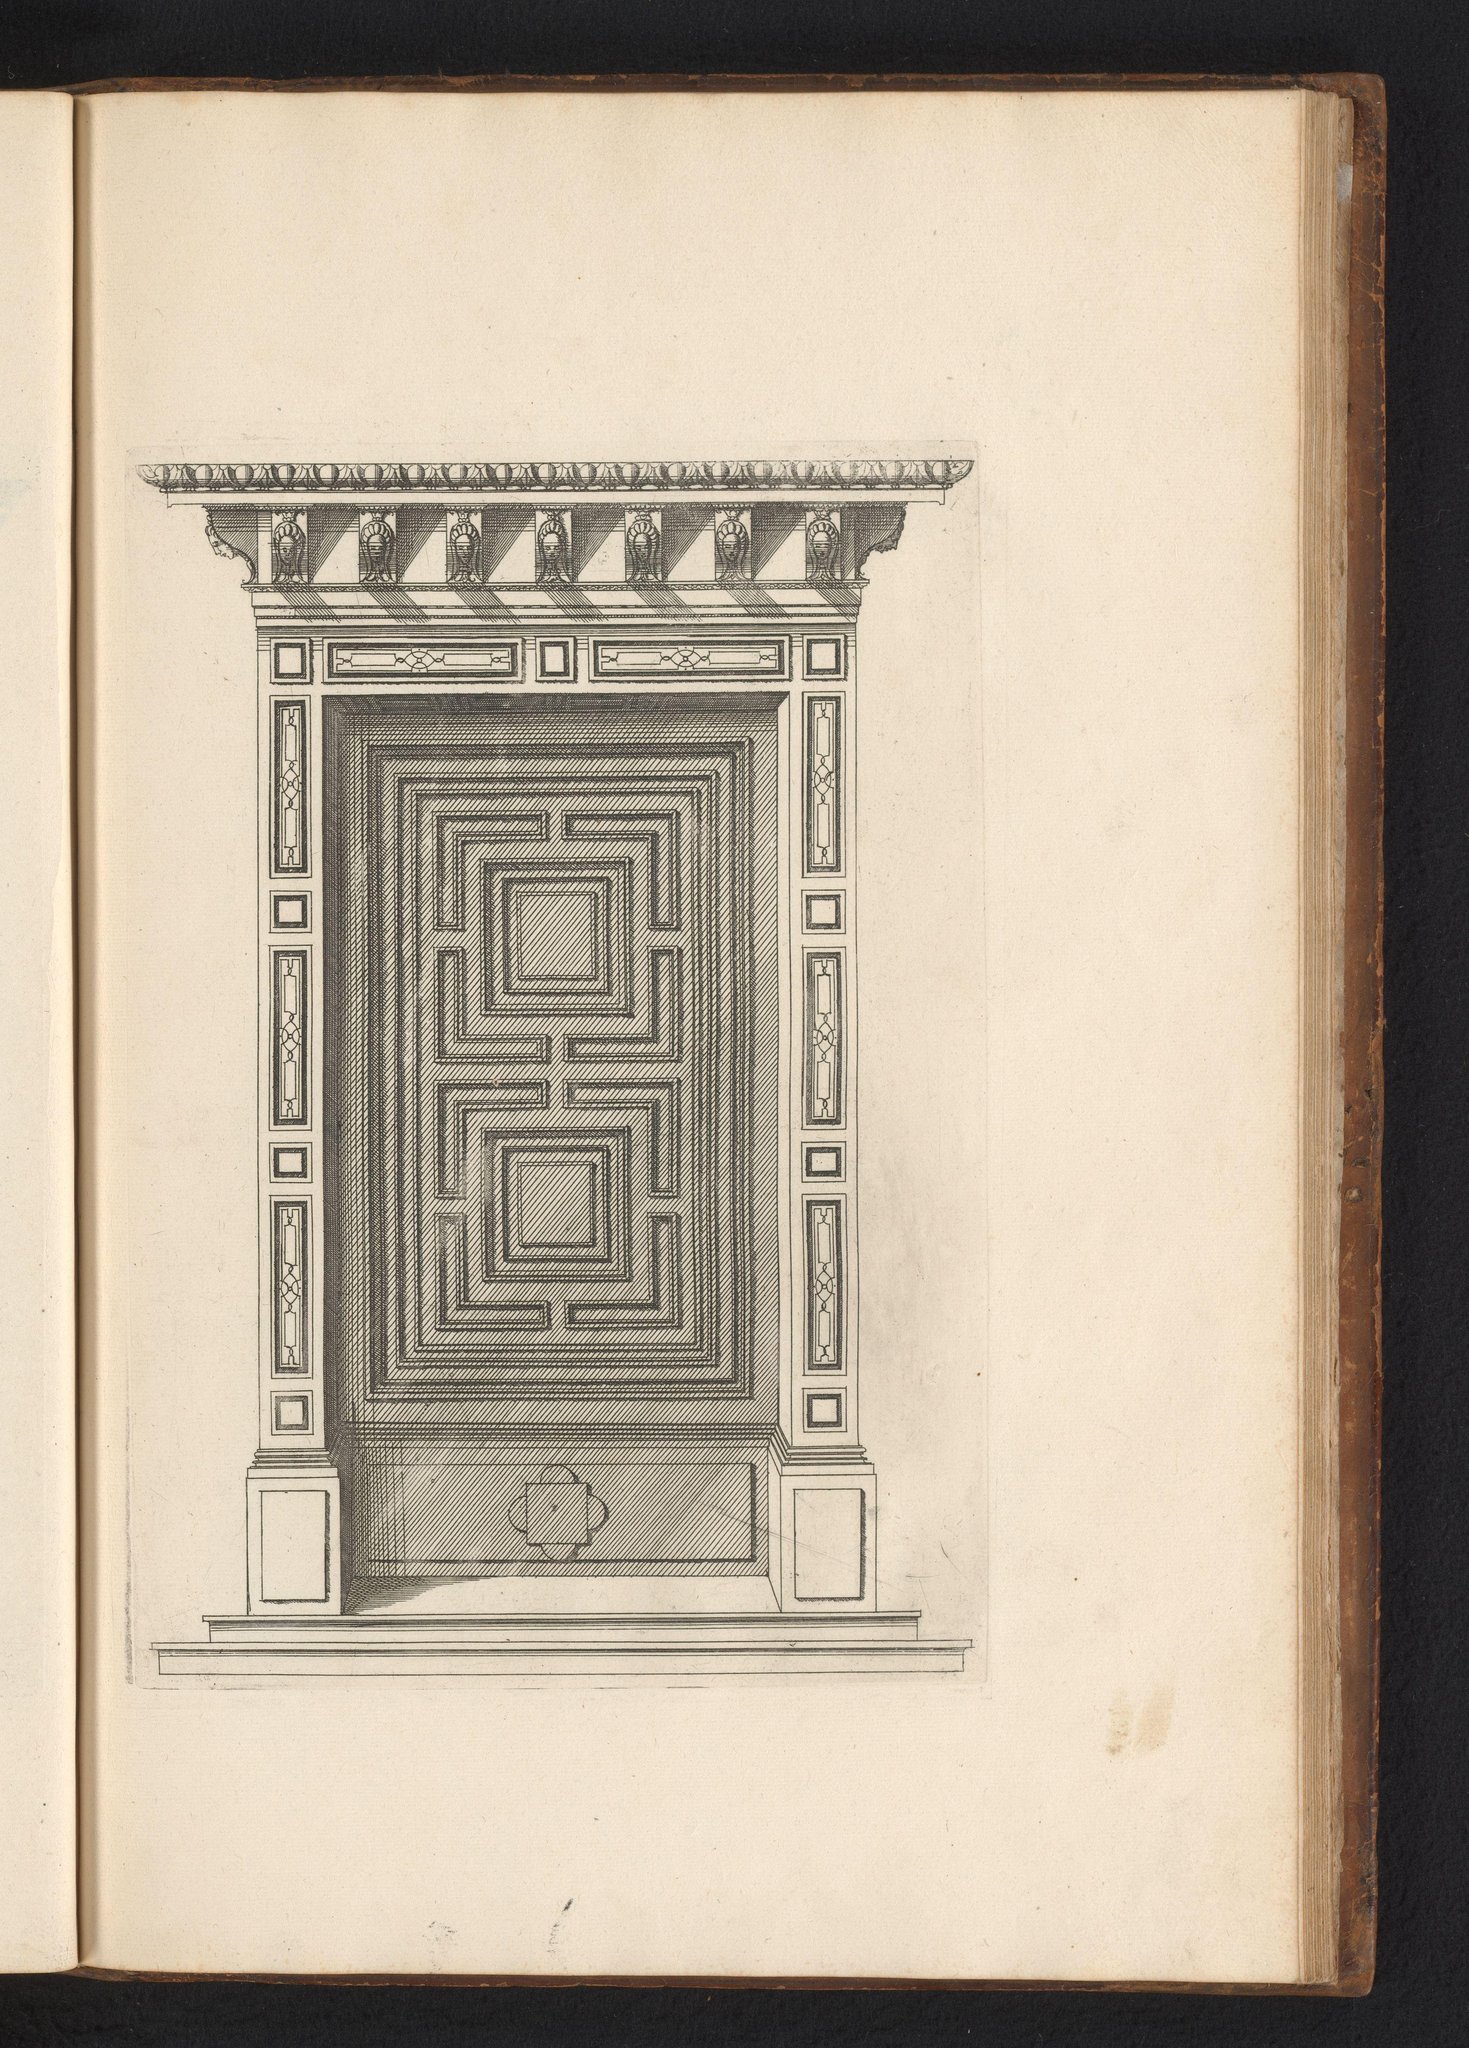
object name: ornament print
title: Deur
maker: jacques androuet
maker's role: draughtsman, print maker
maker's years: 1515-1584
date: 1561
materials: paper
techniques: etching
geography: paris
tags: door, architectural design or model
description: Deur. Onderdeel van 'Seconde livre d'architectvre' (1561): 64 etsen met geornamenteerde architectuuronderdelen.